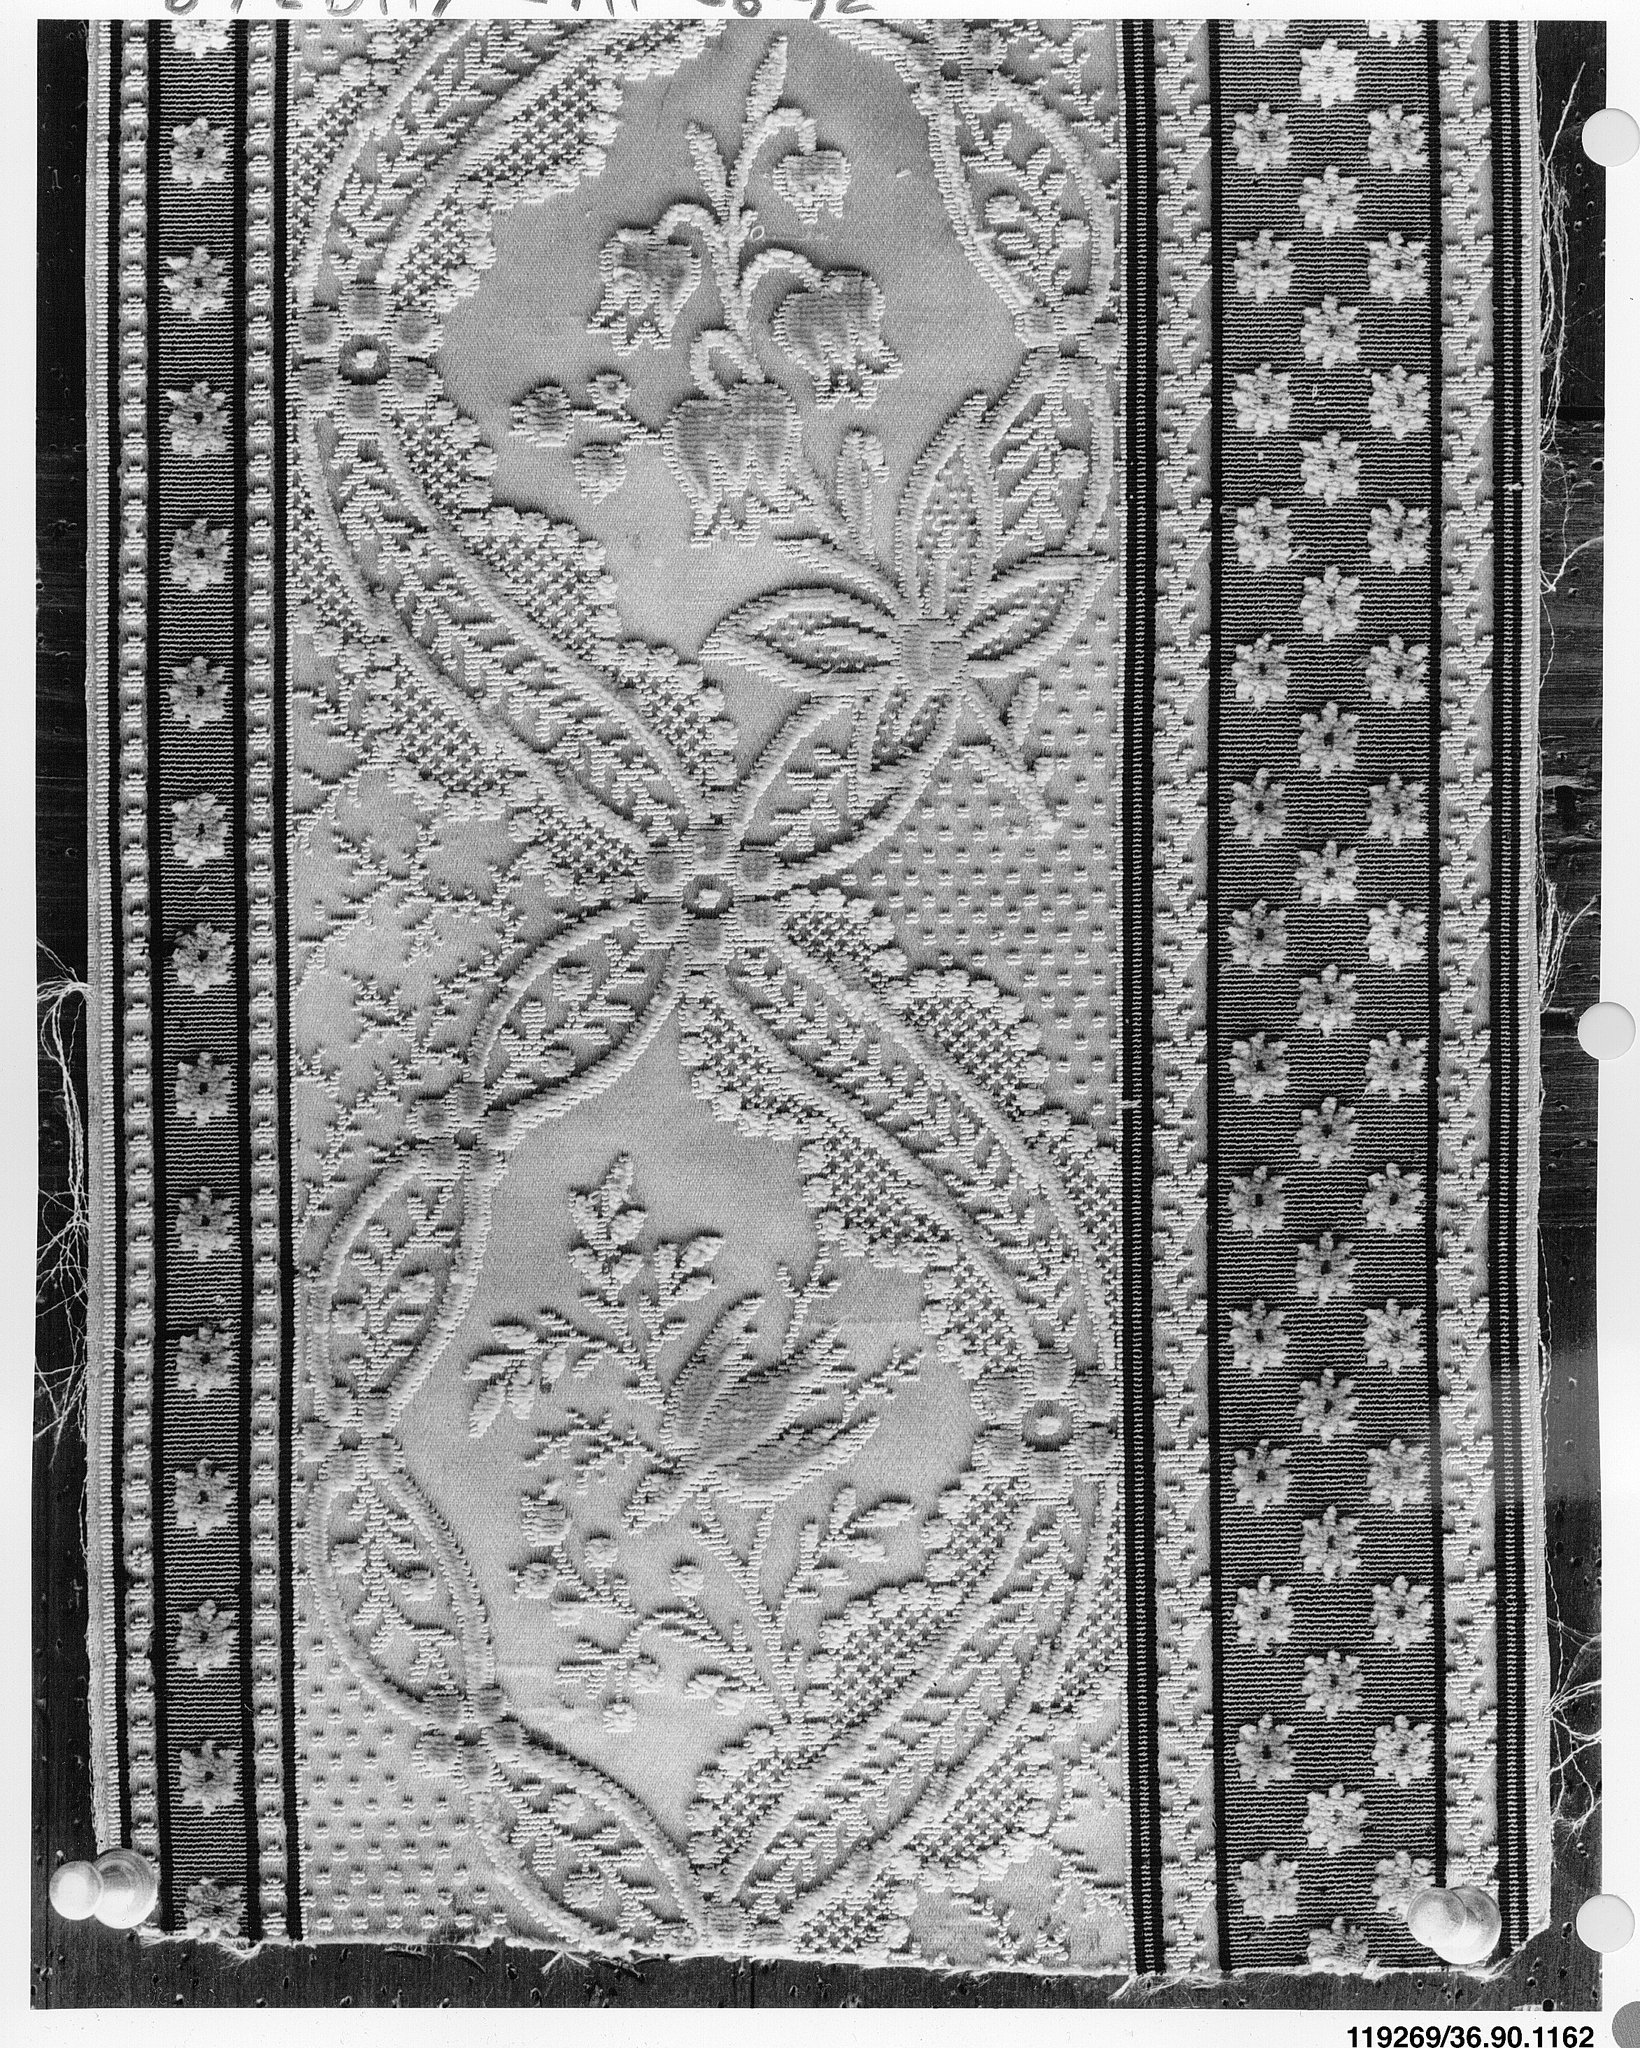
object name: piece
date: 1801-1900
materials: silk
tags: birds,flowers,leaves